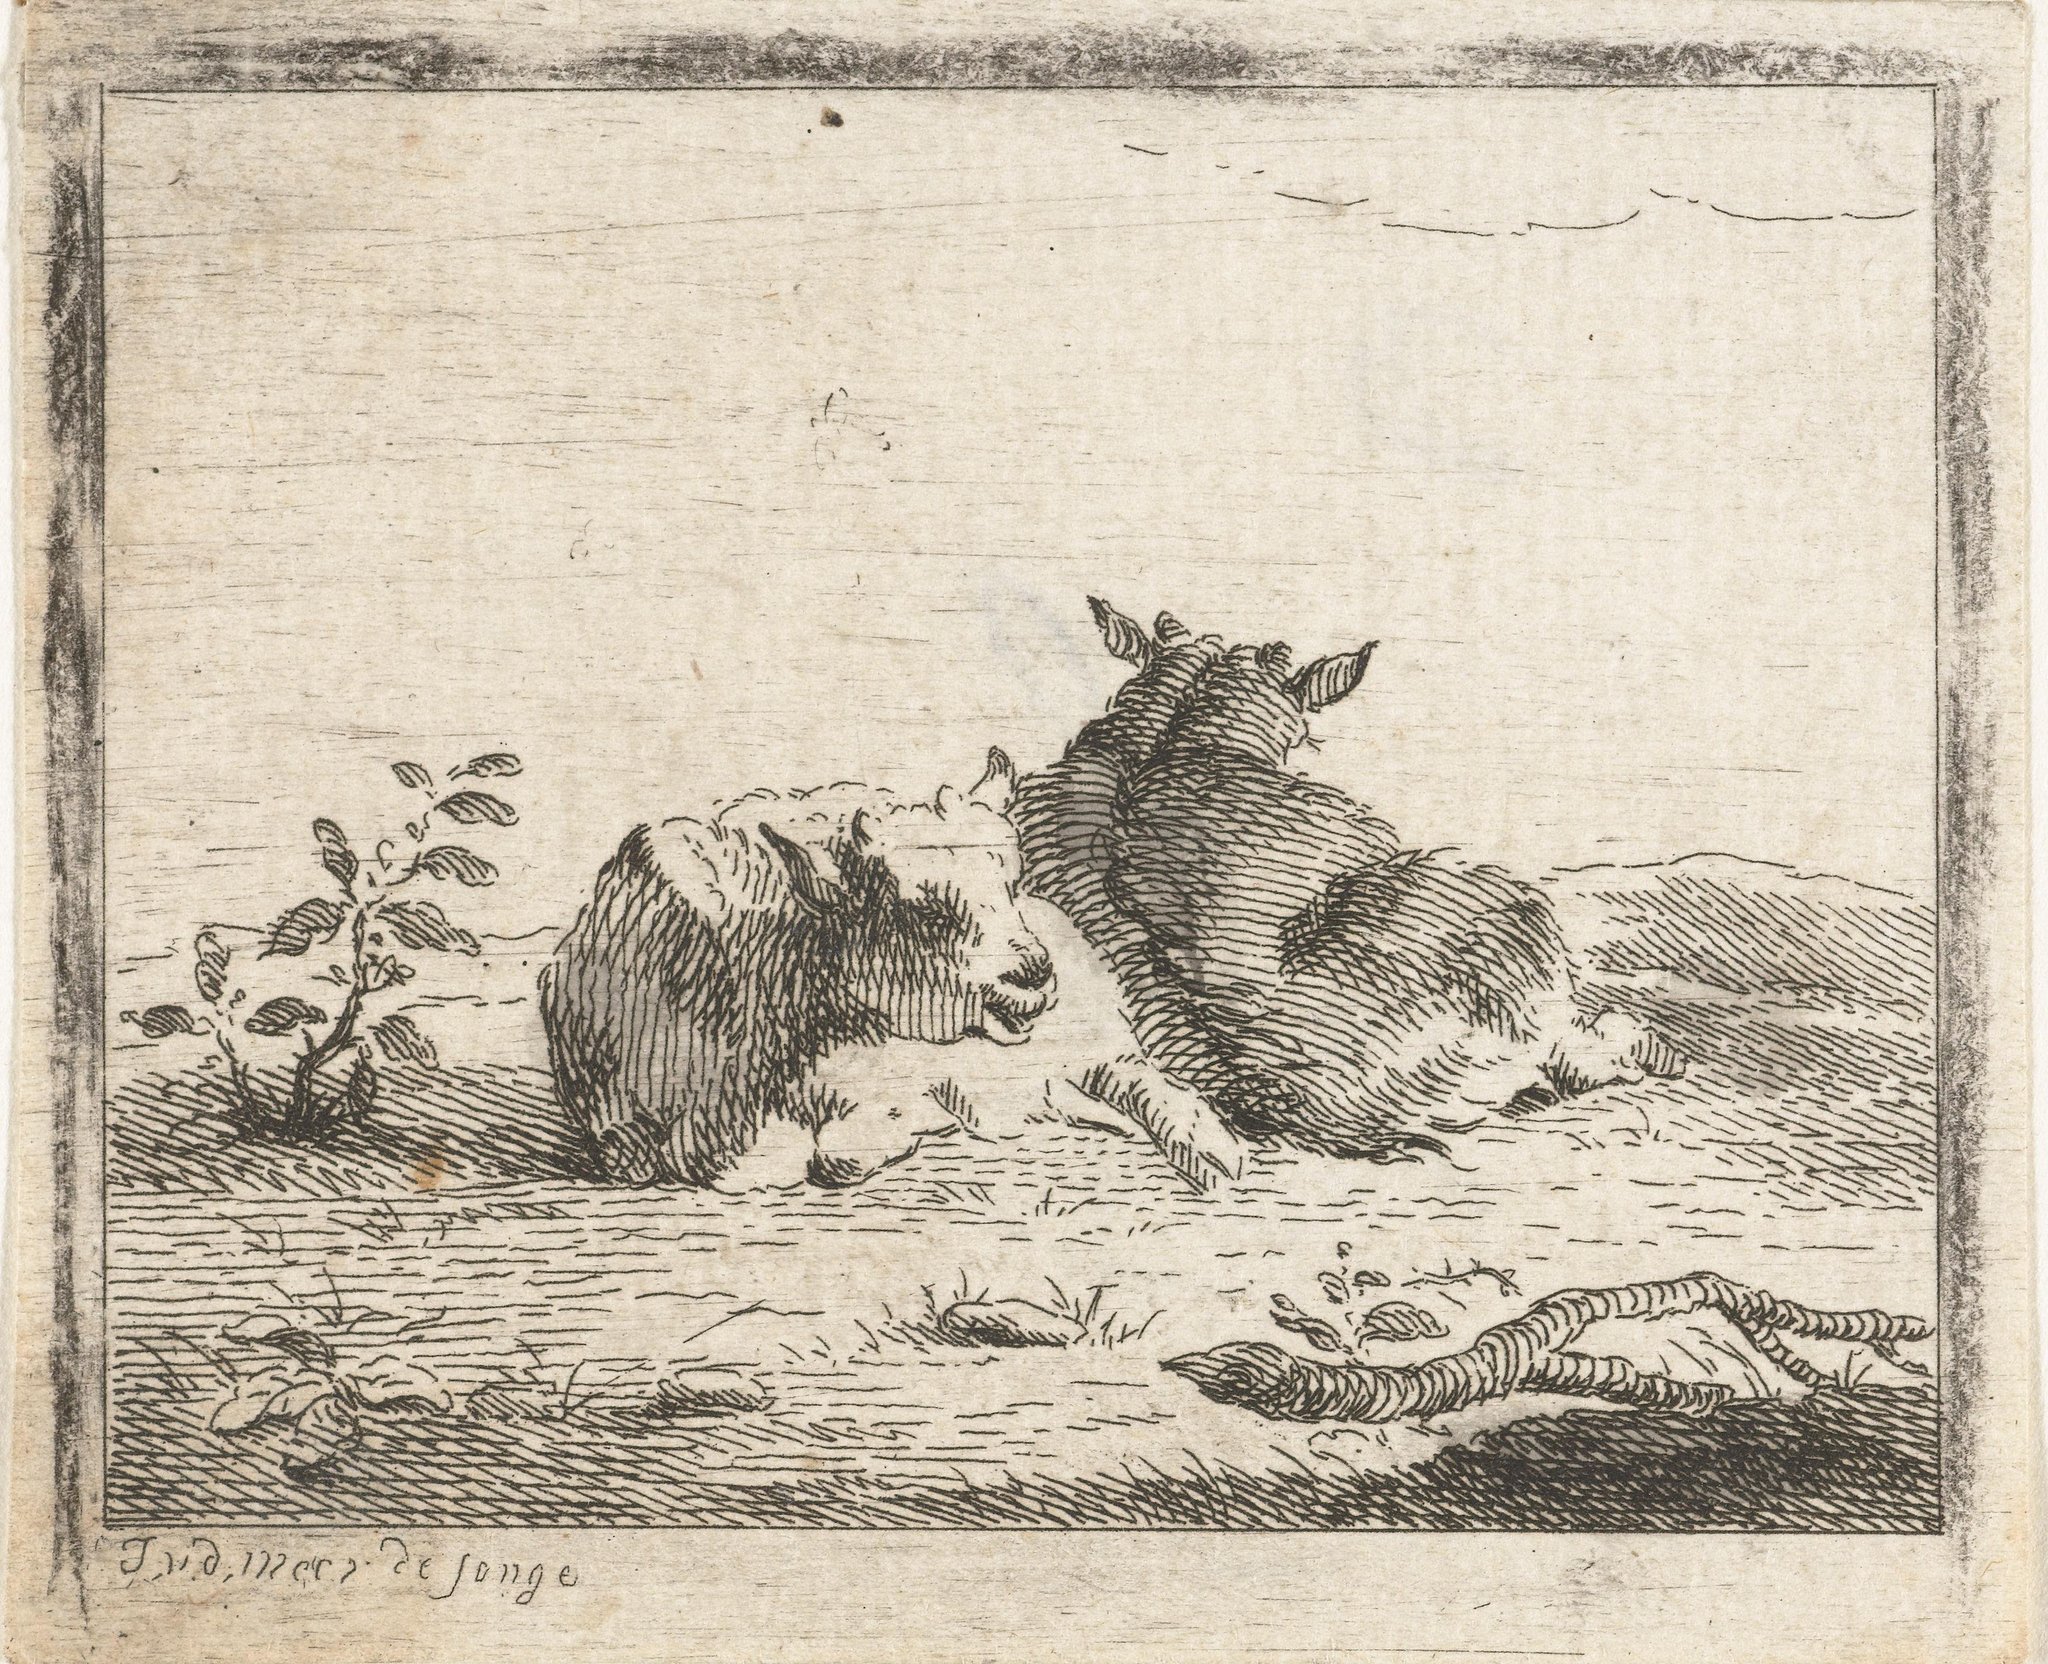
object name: print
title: Twee liggende schapen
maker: jan van der meer (ii)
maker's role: draughtsman, print maker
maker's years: 1656-1705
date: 1671-1705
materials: paper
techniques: etching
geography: haarlem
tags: sheep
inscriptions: number: ‘9’, collector's mark: Lugt 2228